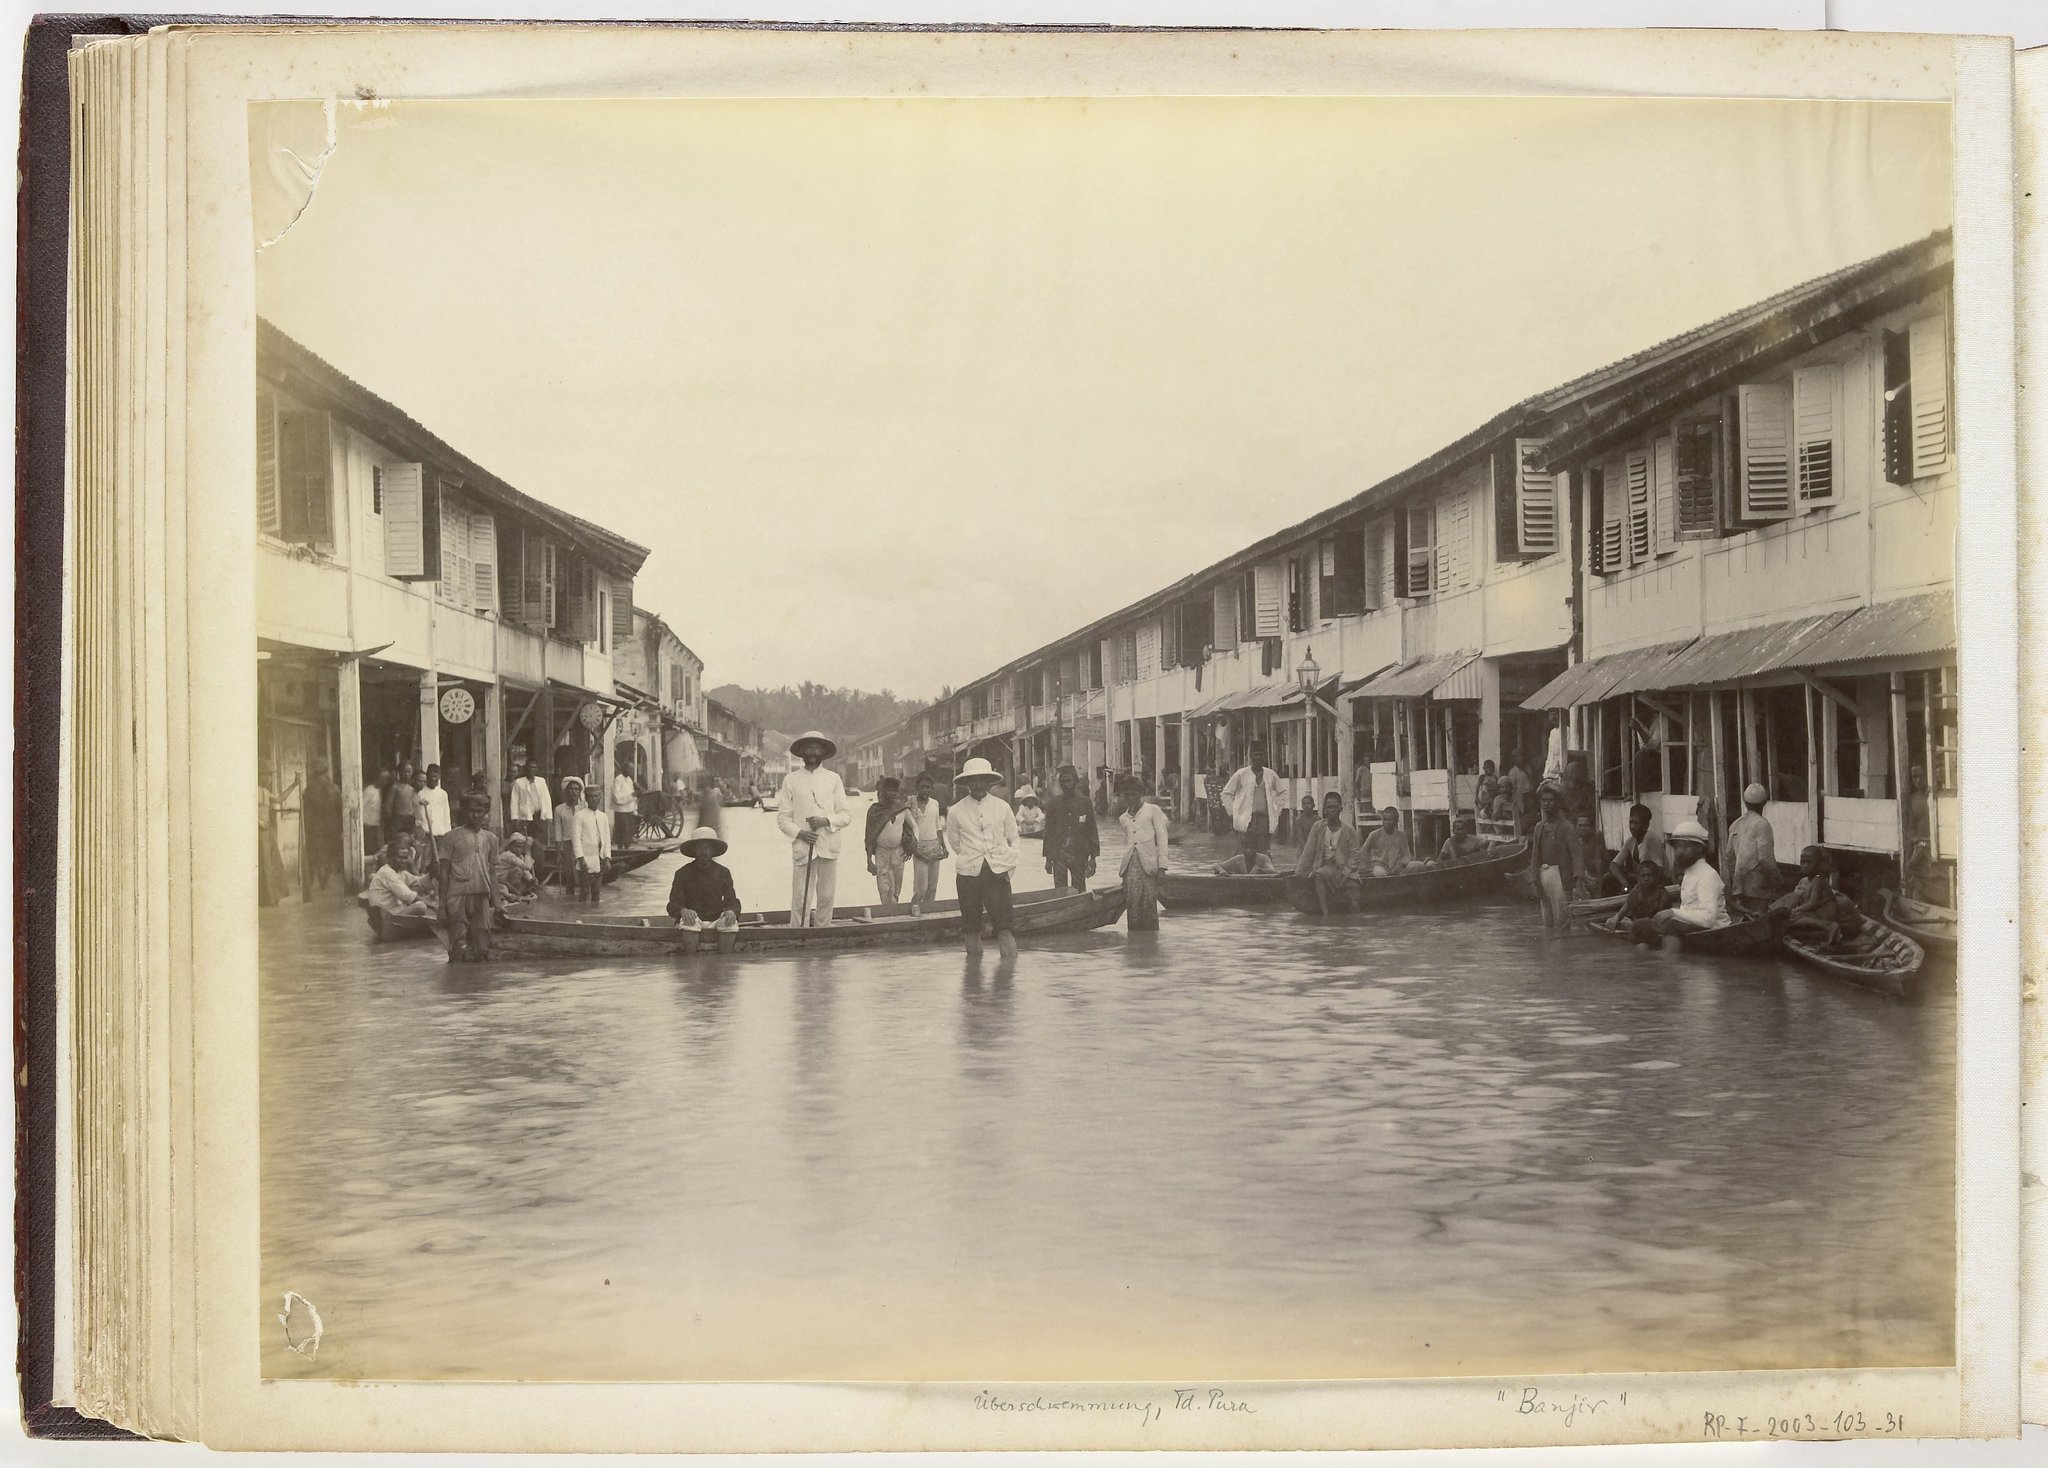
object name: photograph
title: Overstroming van Tandjong Poera, Banjir, Sumatra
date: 1890-1905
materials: cardboard, paper, photographic support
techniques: albumen print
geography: bindjai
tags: sumatra